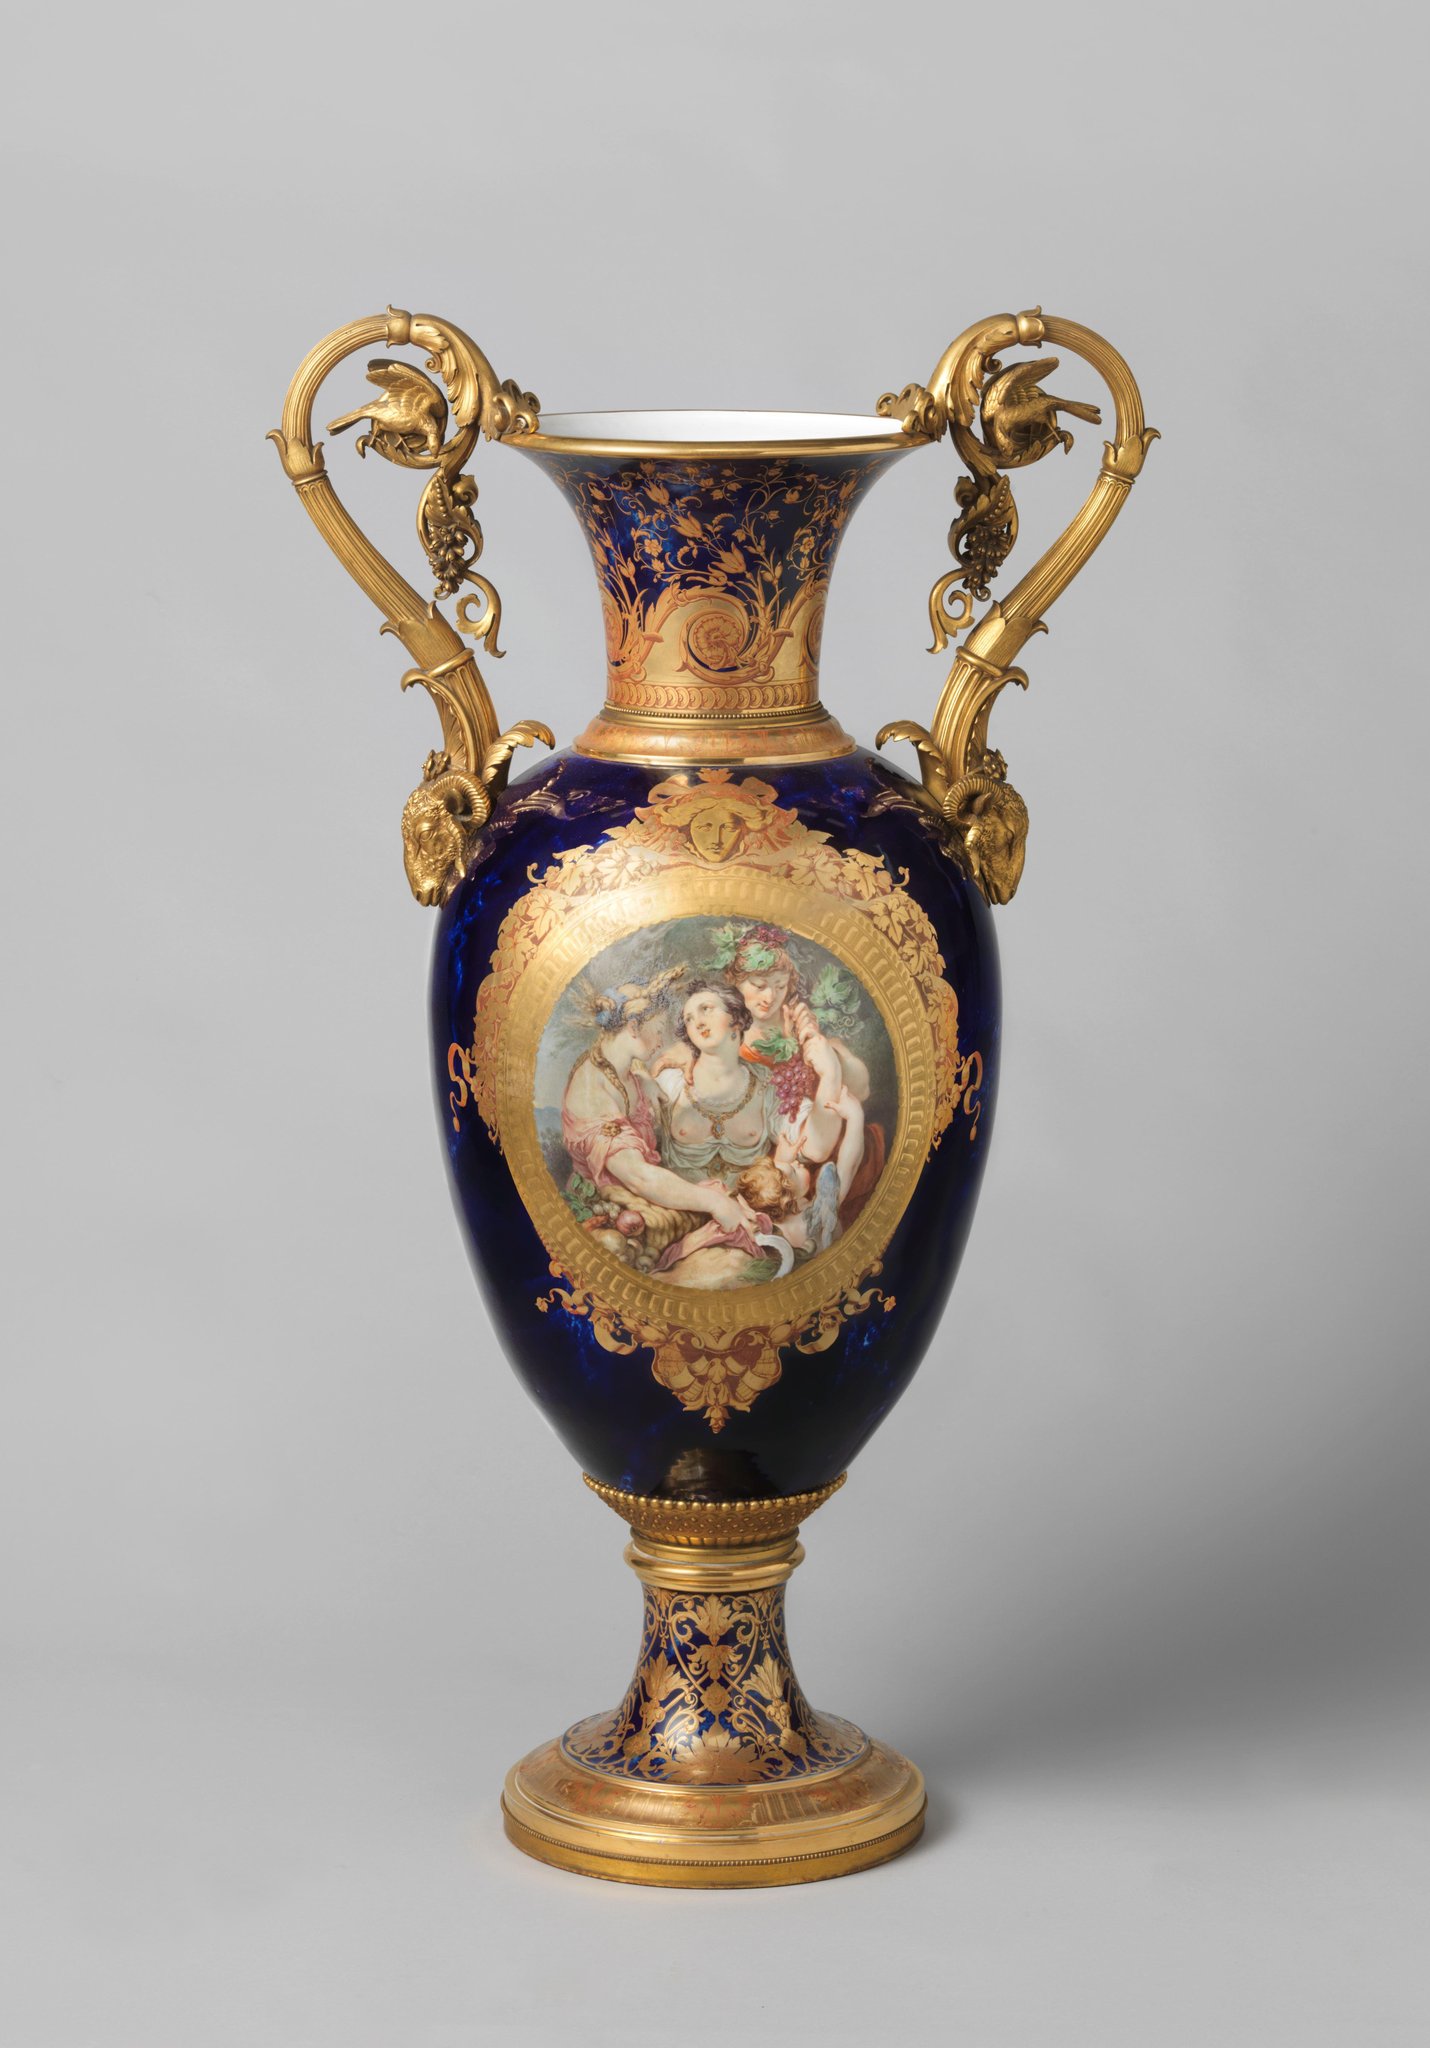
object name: vase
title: Vaas van Sèvres-porselein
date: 1849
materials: metal, porcelain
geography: france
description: Two vases. Porcelain with gilt bronze mounts. Sèvres, 1849. On loan from H.R.H. Princess Juliana of the Netherlands.